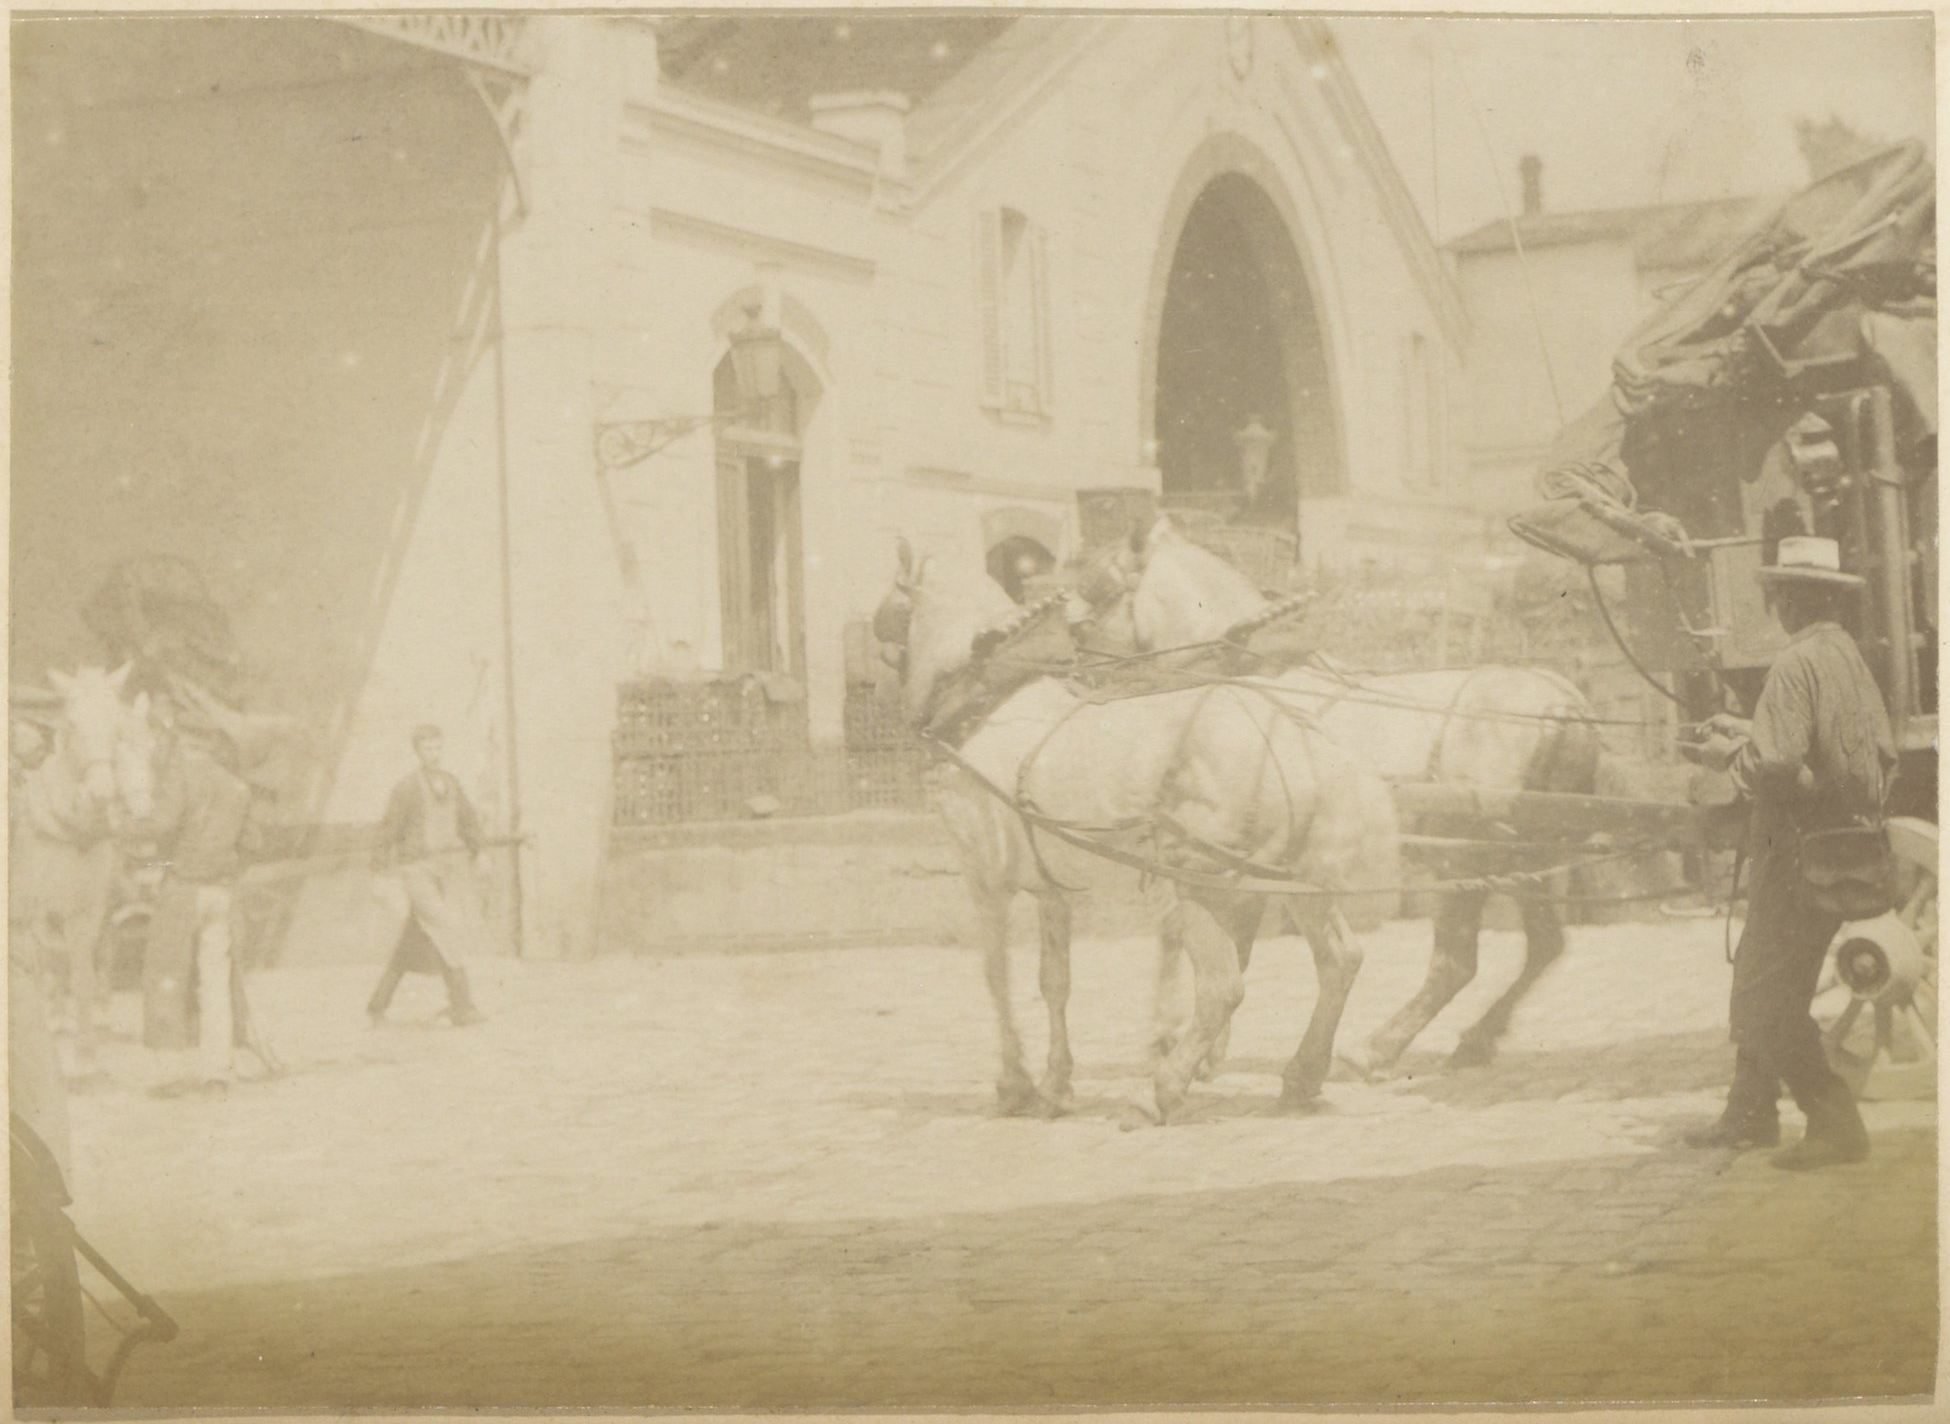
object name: photograph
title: Paardenkar op het terrein van distilleerderij Delizy & Doistau Fils in Pantin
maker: Anonymous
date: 1900-1910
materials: paper, photographic support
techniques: albumen print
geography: pantin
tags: animal traction, animal-drawn vehicle (carriage etc.), factory-building, alcoholic drinks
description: Onderdeel van Fotoalbum van een Franse amateurfotograaf met opnames van een familie, distilleerderij Delizy & Doistau Fils, het leger en bezienswaardigheden in Frankrijk.